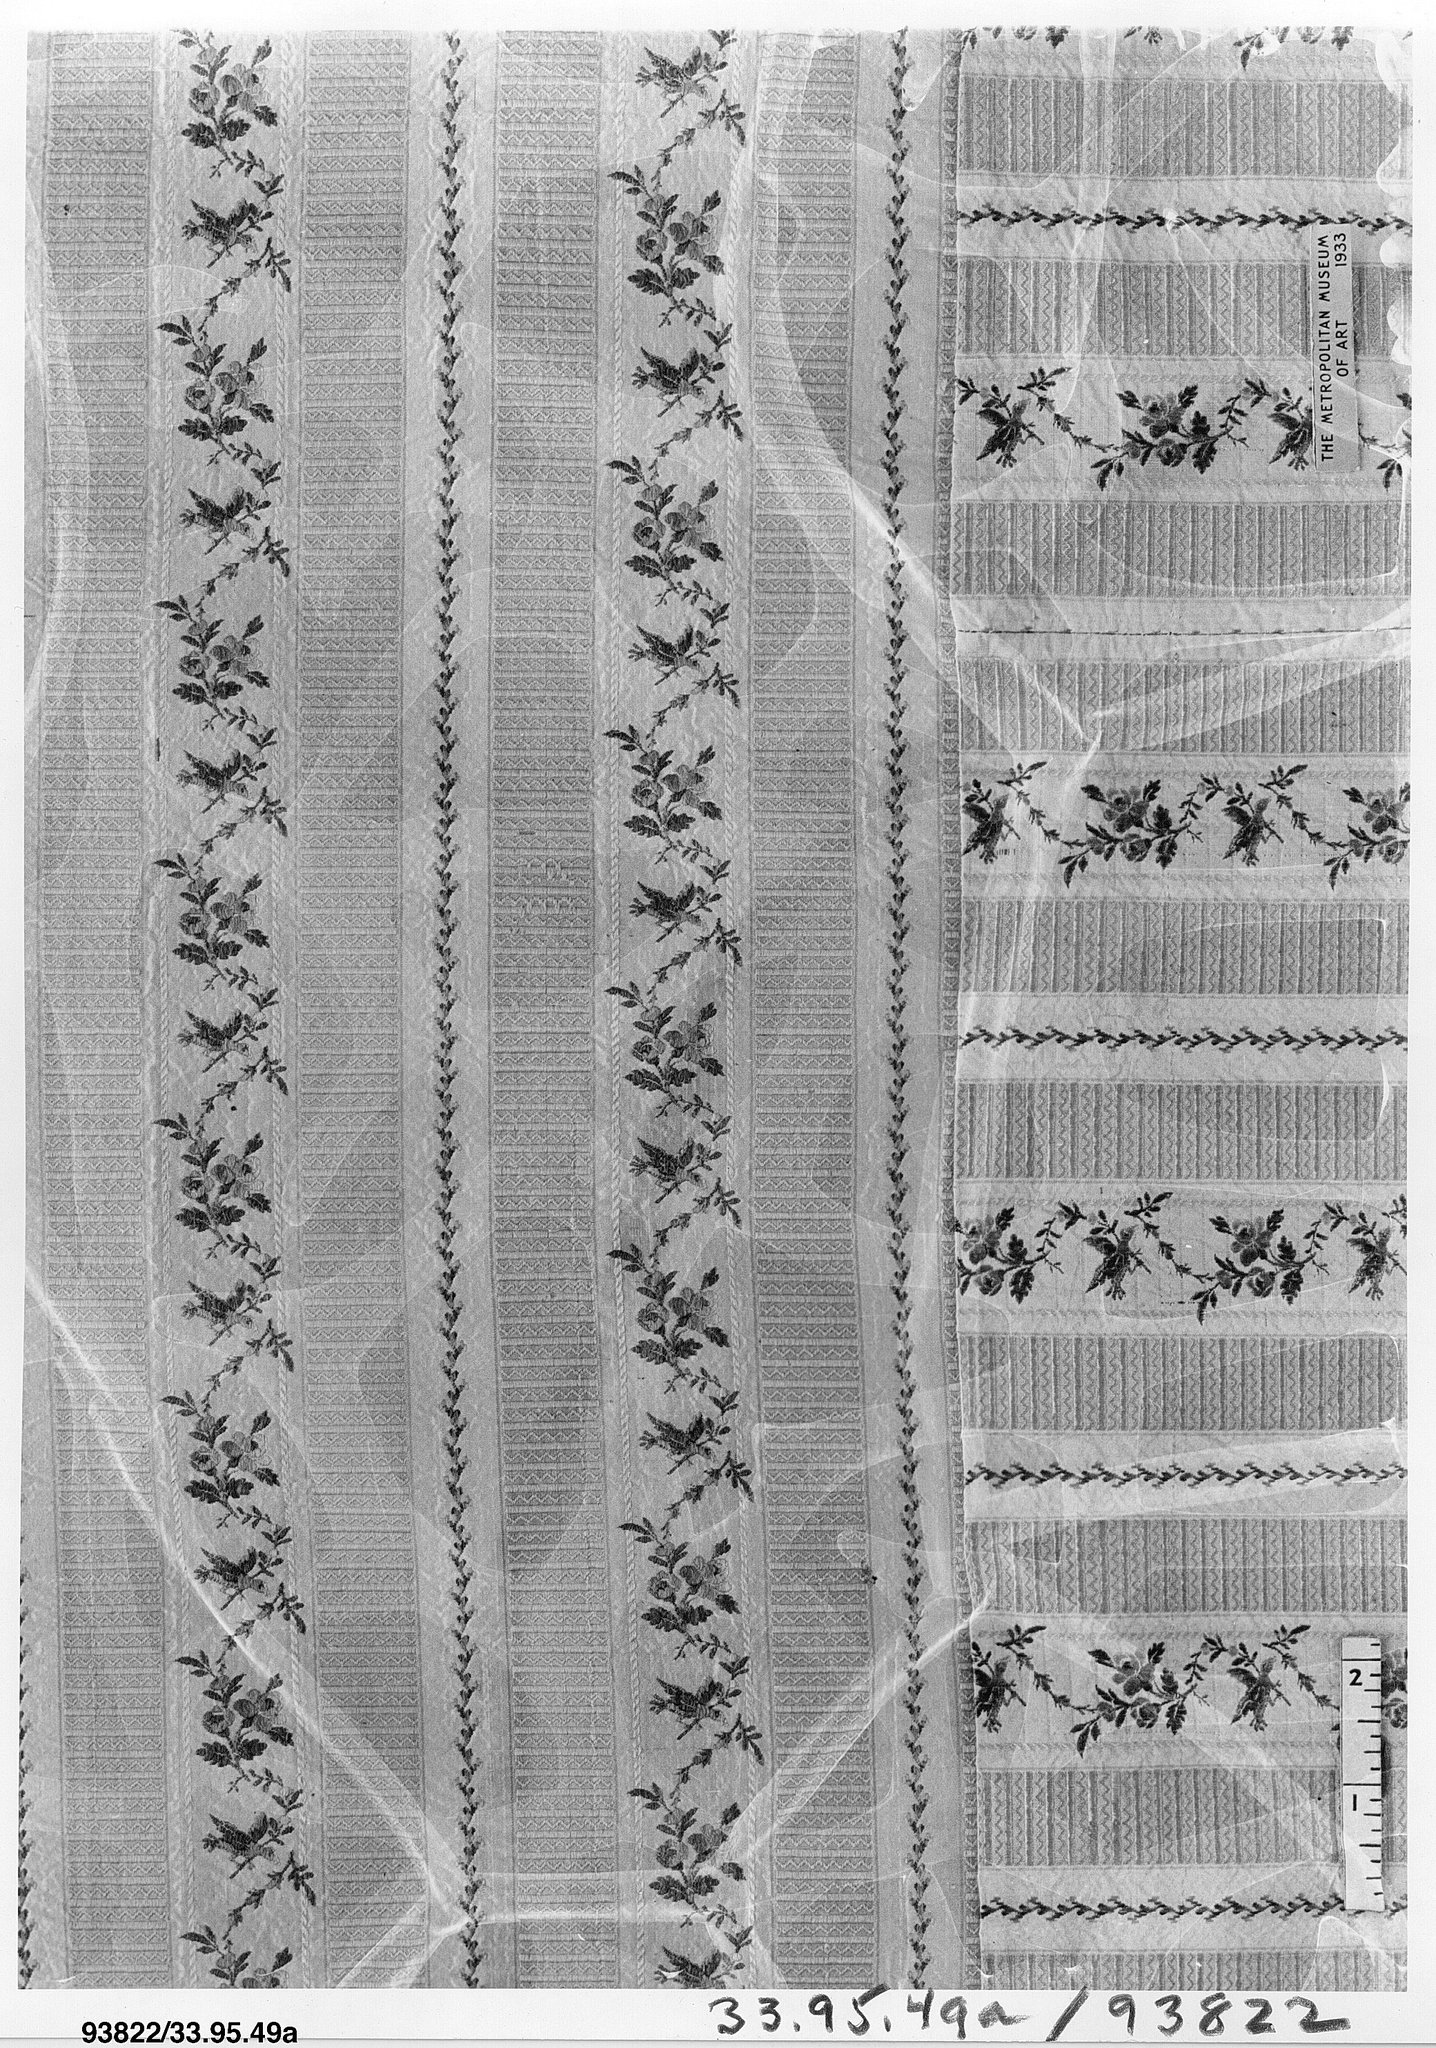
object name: piece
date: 1701-1800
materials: silk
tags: flowers,leaves